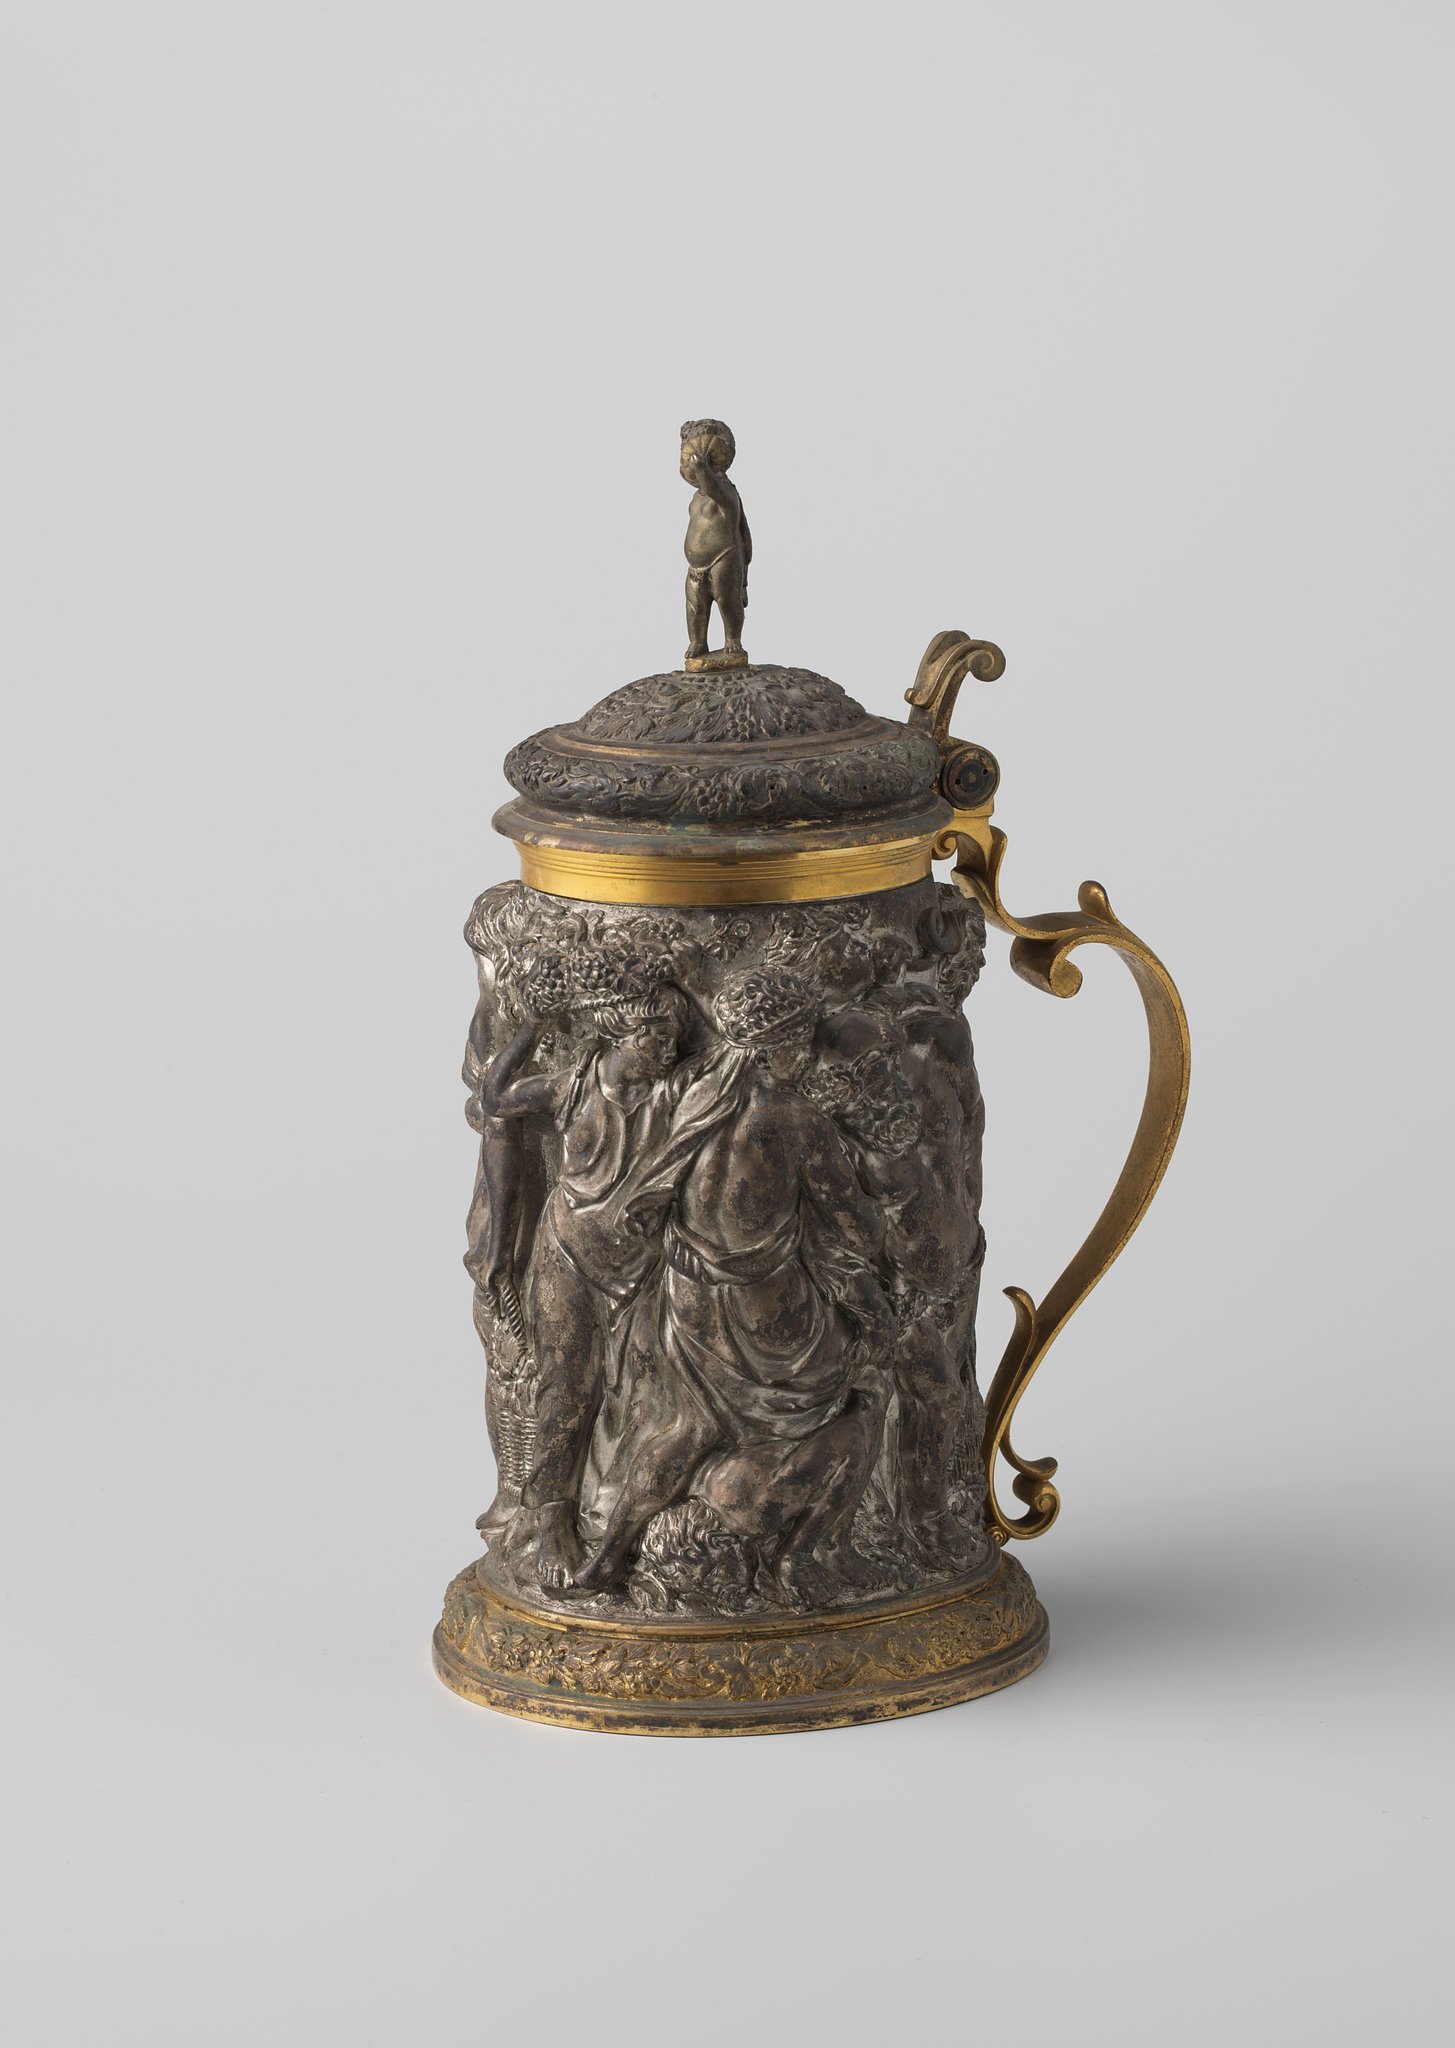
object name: ewer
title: Galvanoplastische reproductie van een kan met de Triomf van Bacchus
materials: copper, silver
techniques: gilding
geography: london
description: Galvanoplastische reproductie van een kan met deksel met de Triomf van Bacchus. Gedeeltelijk verguld.